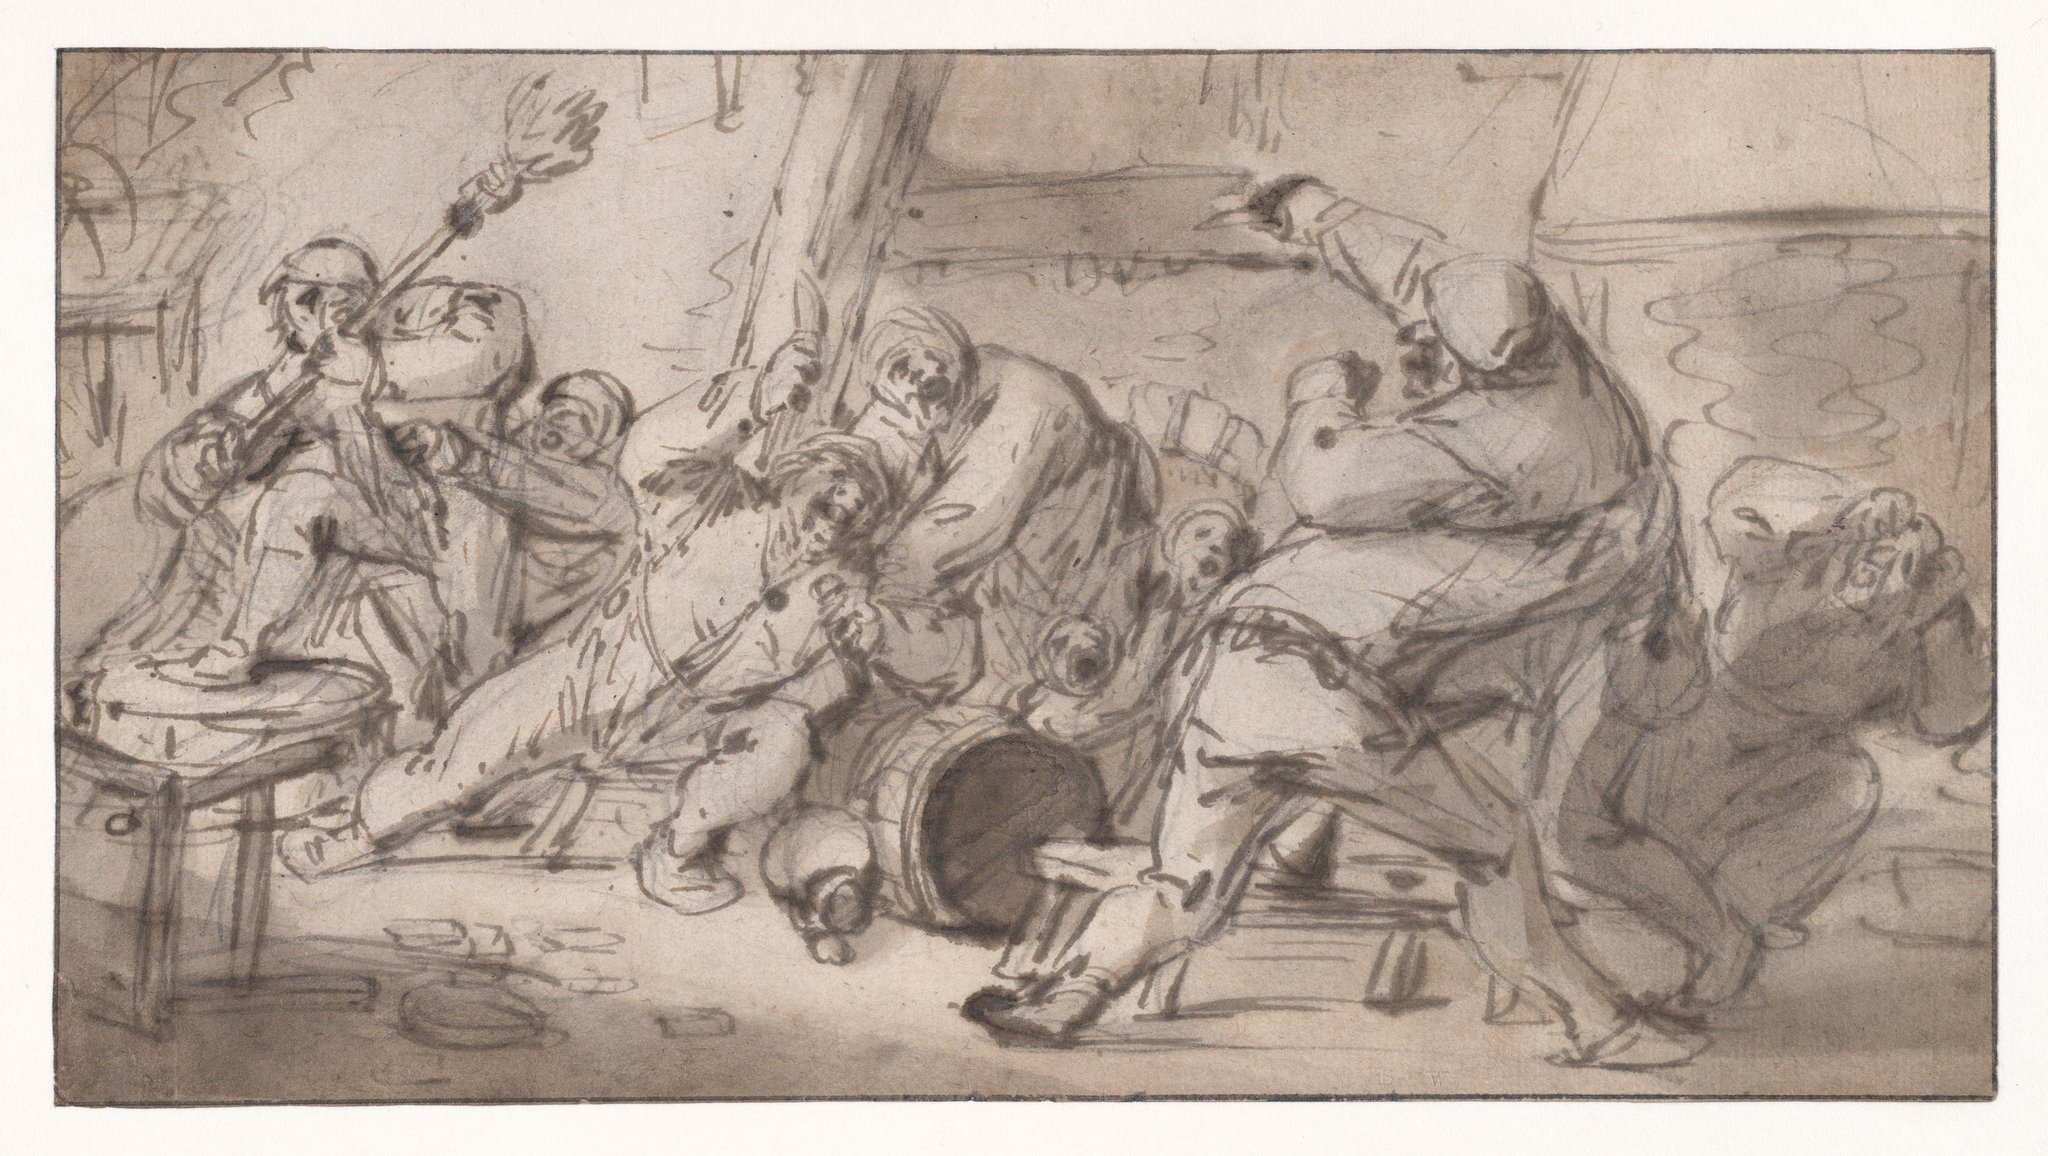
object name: drawing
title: Peasants fighting in an inn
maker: adriaen van ostade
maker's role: artist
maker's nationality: dutch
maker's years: 1610-1685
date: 1634-1666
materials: chalk, ink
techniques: brush, pen, wash